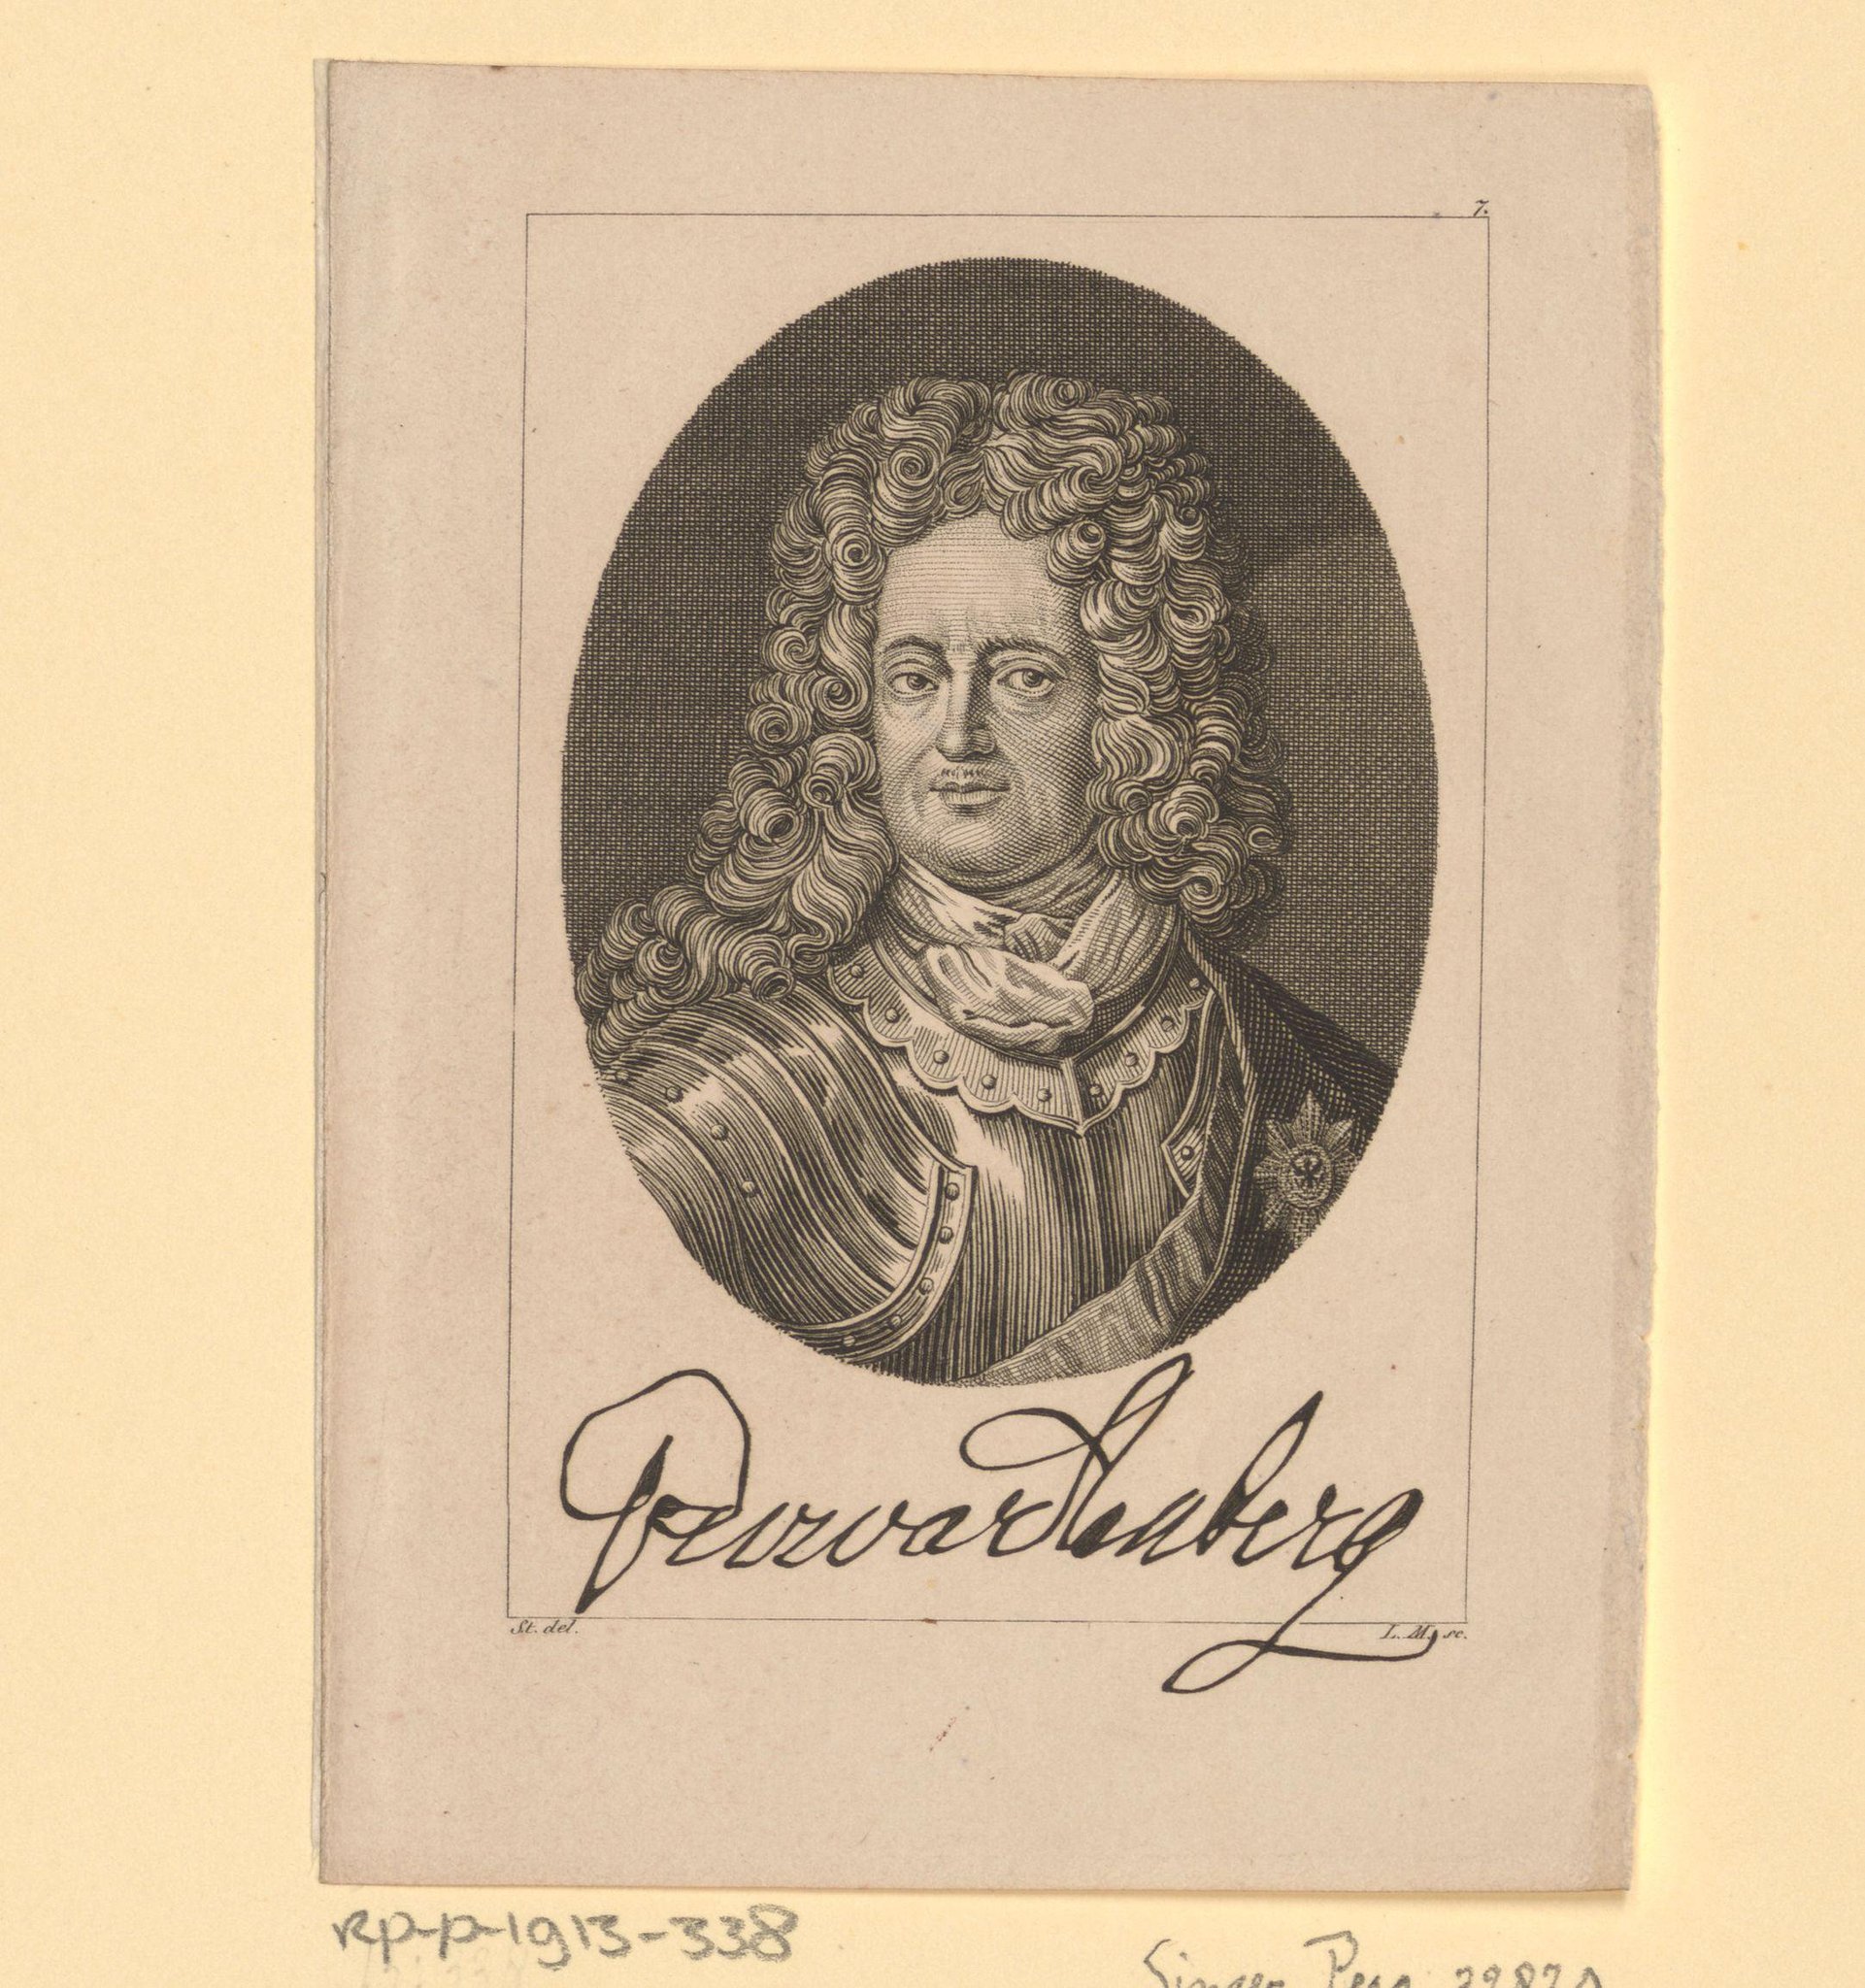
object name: print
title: Portret van Johann Casimir Kolbe von Wartenberg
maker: Anonymous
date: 1750-1850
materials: paper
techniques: engraving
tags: historical persons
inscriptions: monogram: ‘S.t.’, monogram: ‘L.M.’, collector's mark: Lugt 2228